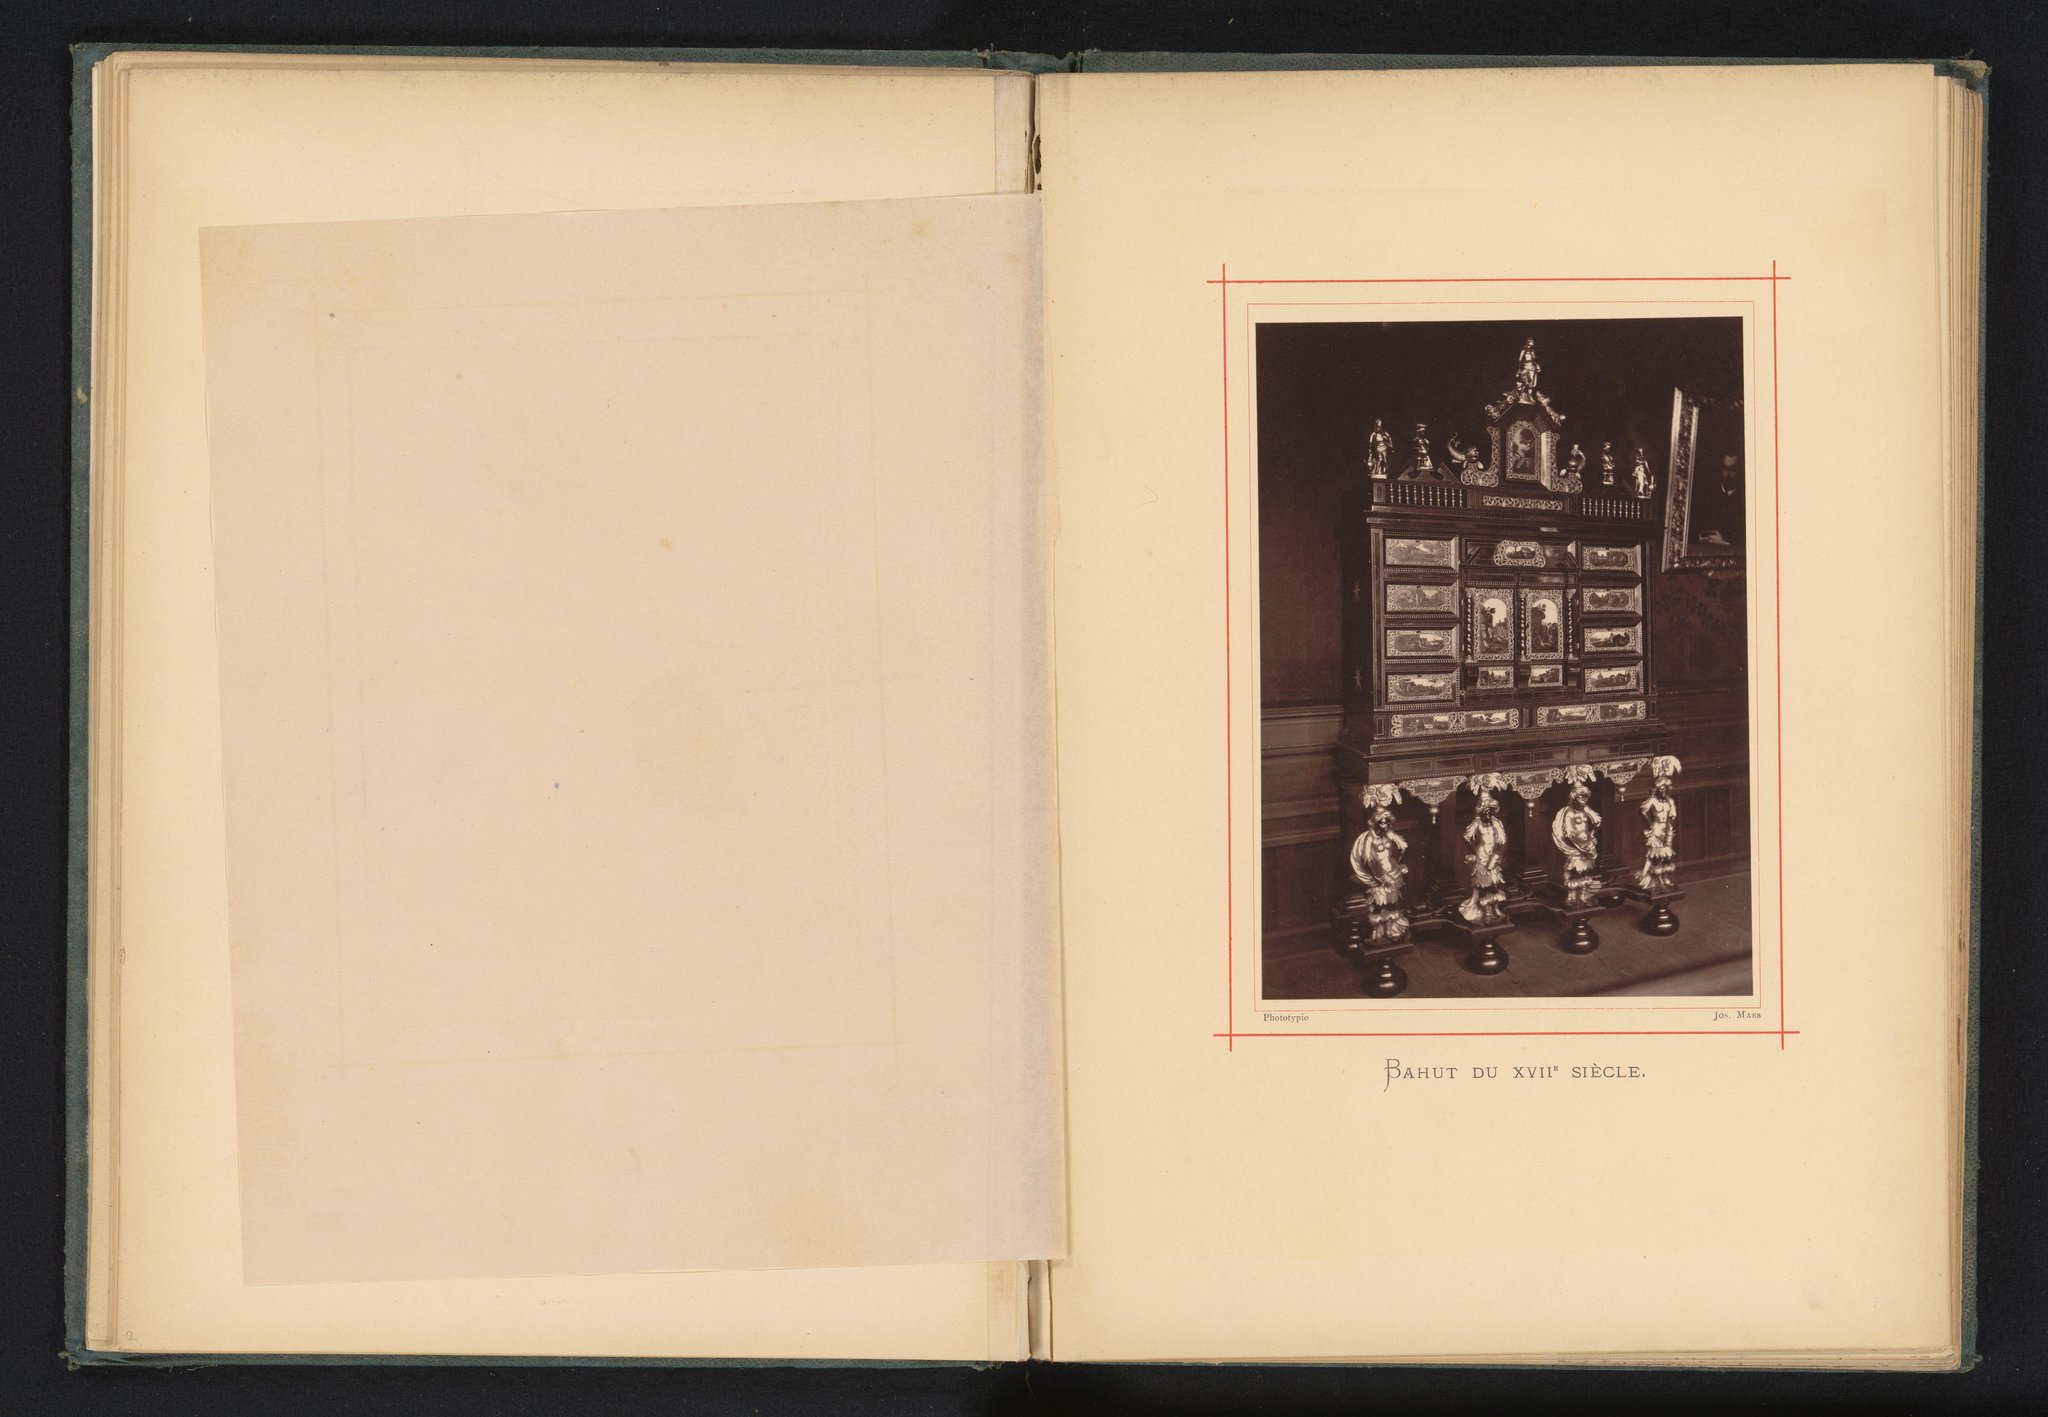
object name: page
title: Pronkkast in het huis van Christoffel Plantijn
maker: joseph maes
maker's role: fotograaf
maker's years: 1838-1908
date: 1873-1878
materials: paper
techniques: woodburytype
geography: antwerp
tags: 'kunstschrank', interior of the house